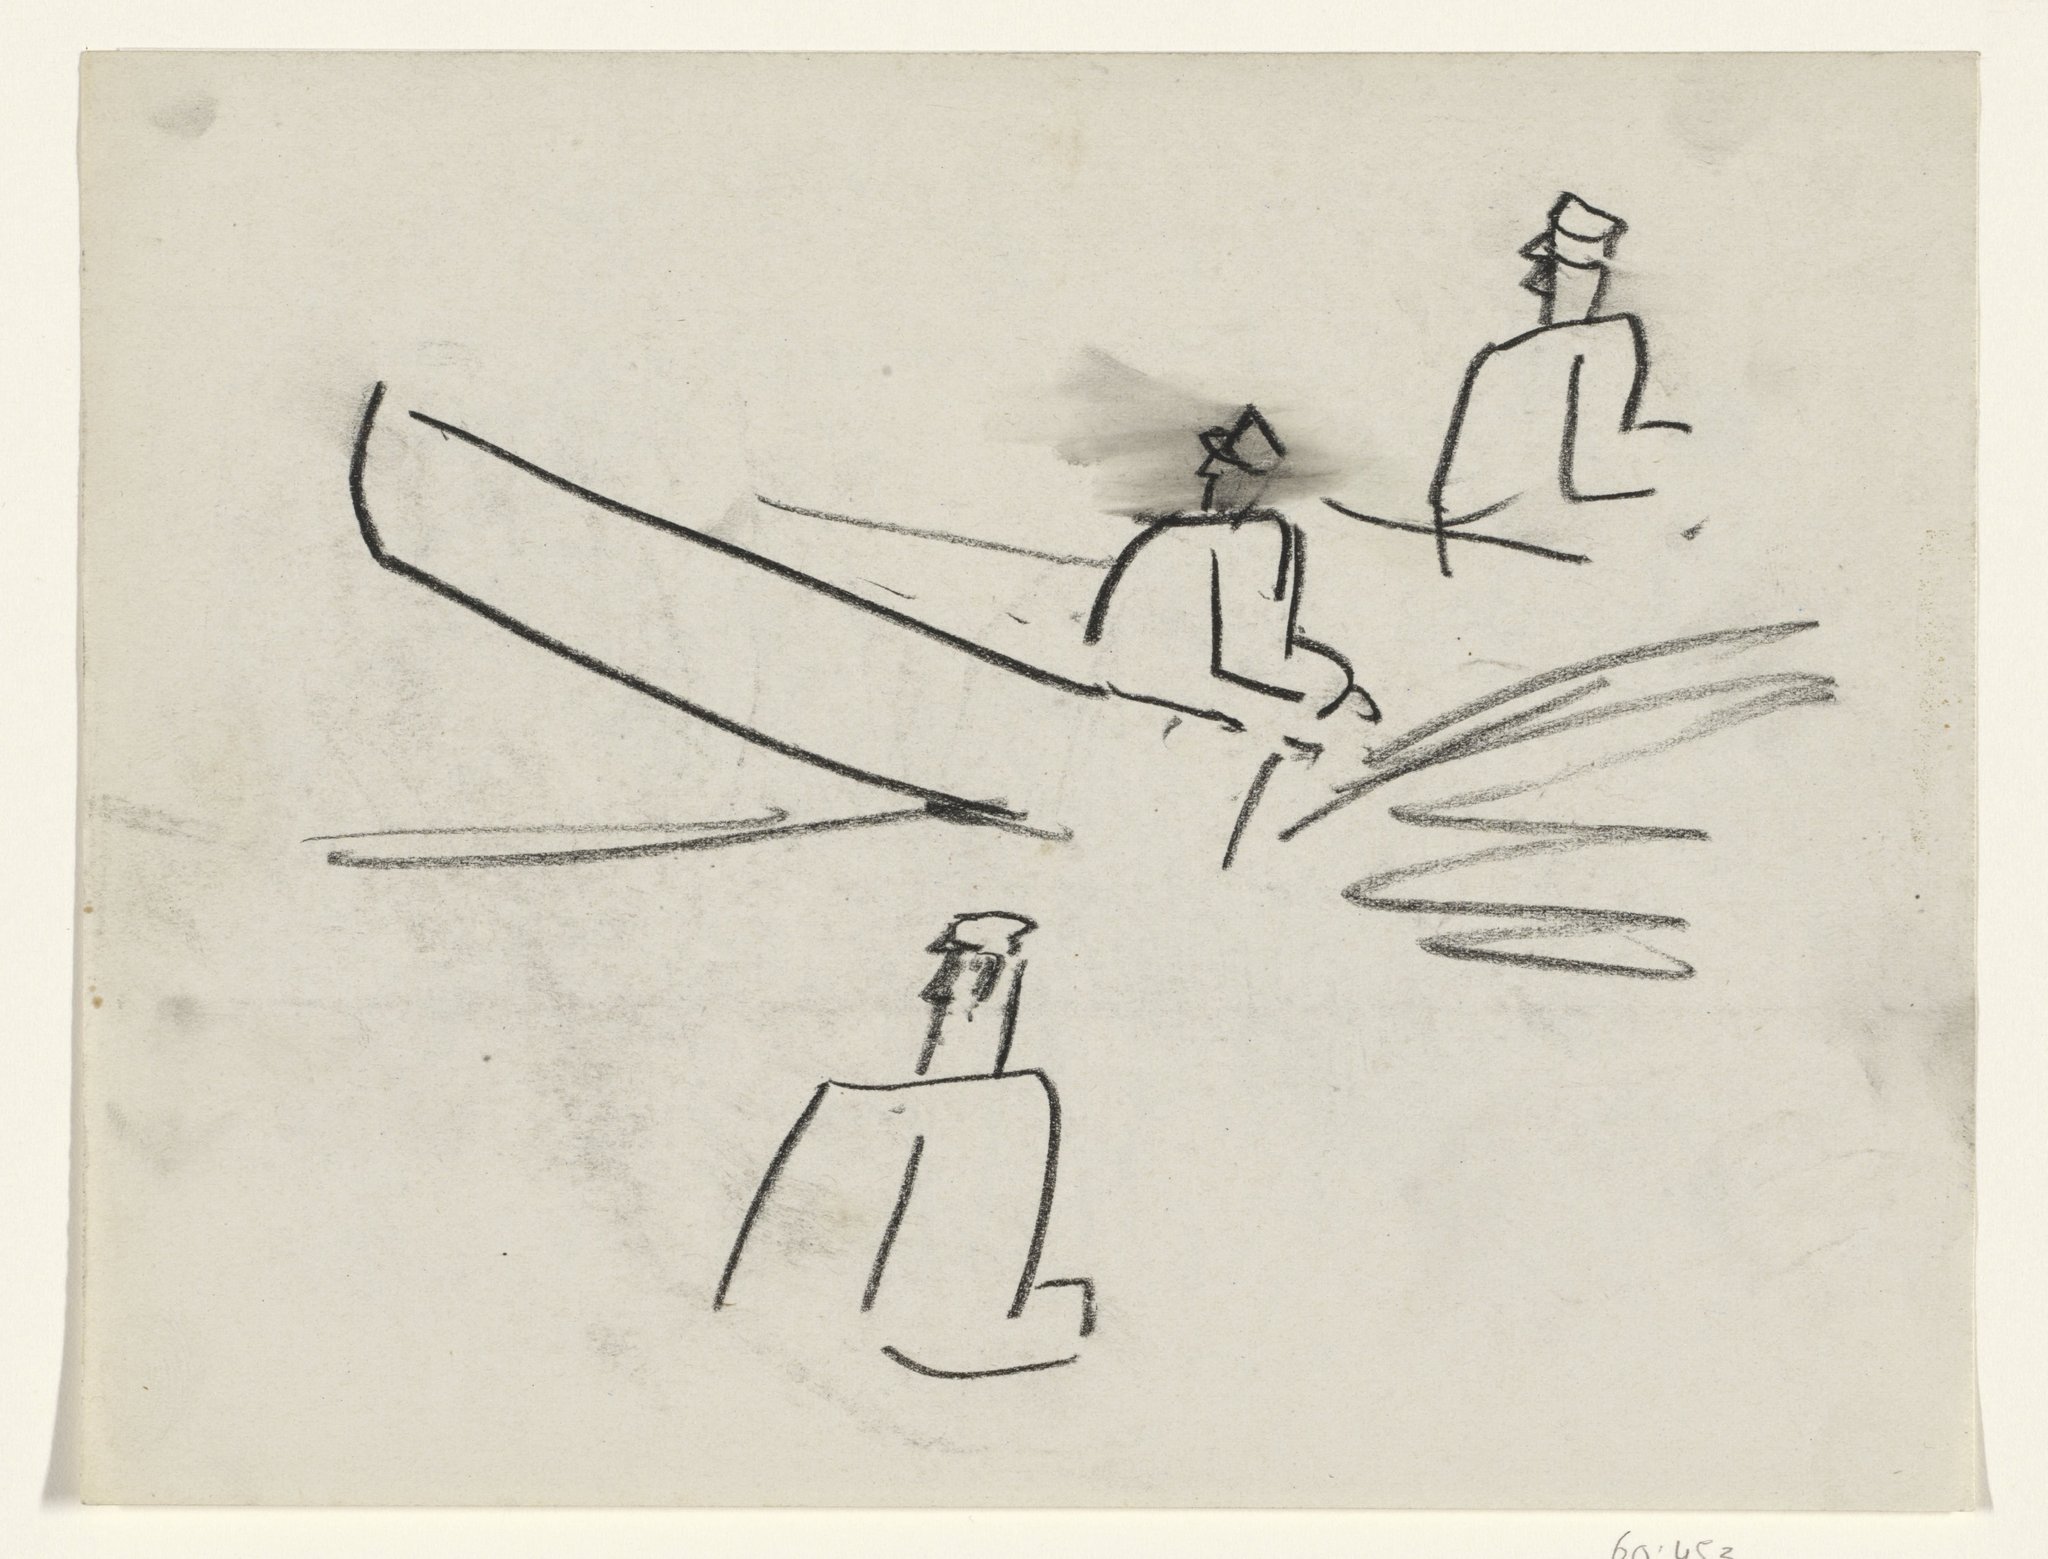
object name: drawing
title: Man in een motorboot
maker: leo gestel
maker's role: draughtsman, print maker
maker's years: 1881-1941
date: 1891-1941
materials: chalk, paper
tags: rowing-boat, canoe, etc., male sex; man, steamship, motorship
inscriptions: collector's mark: Lugt 2228